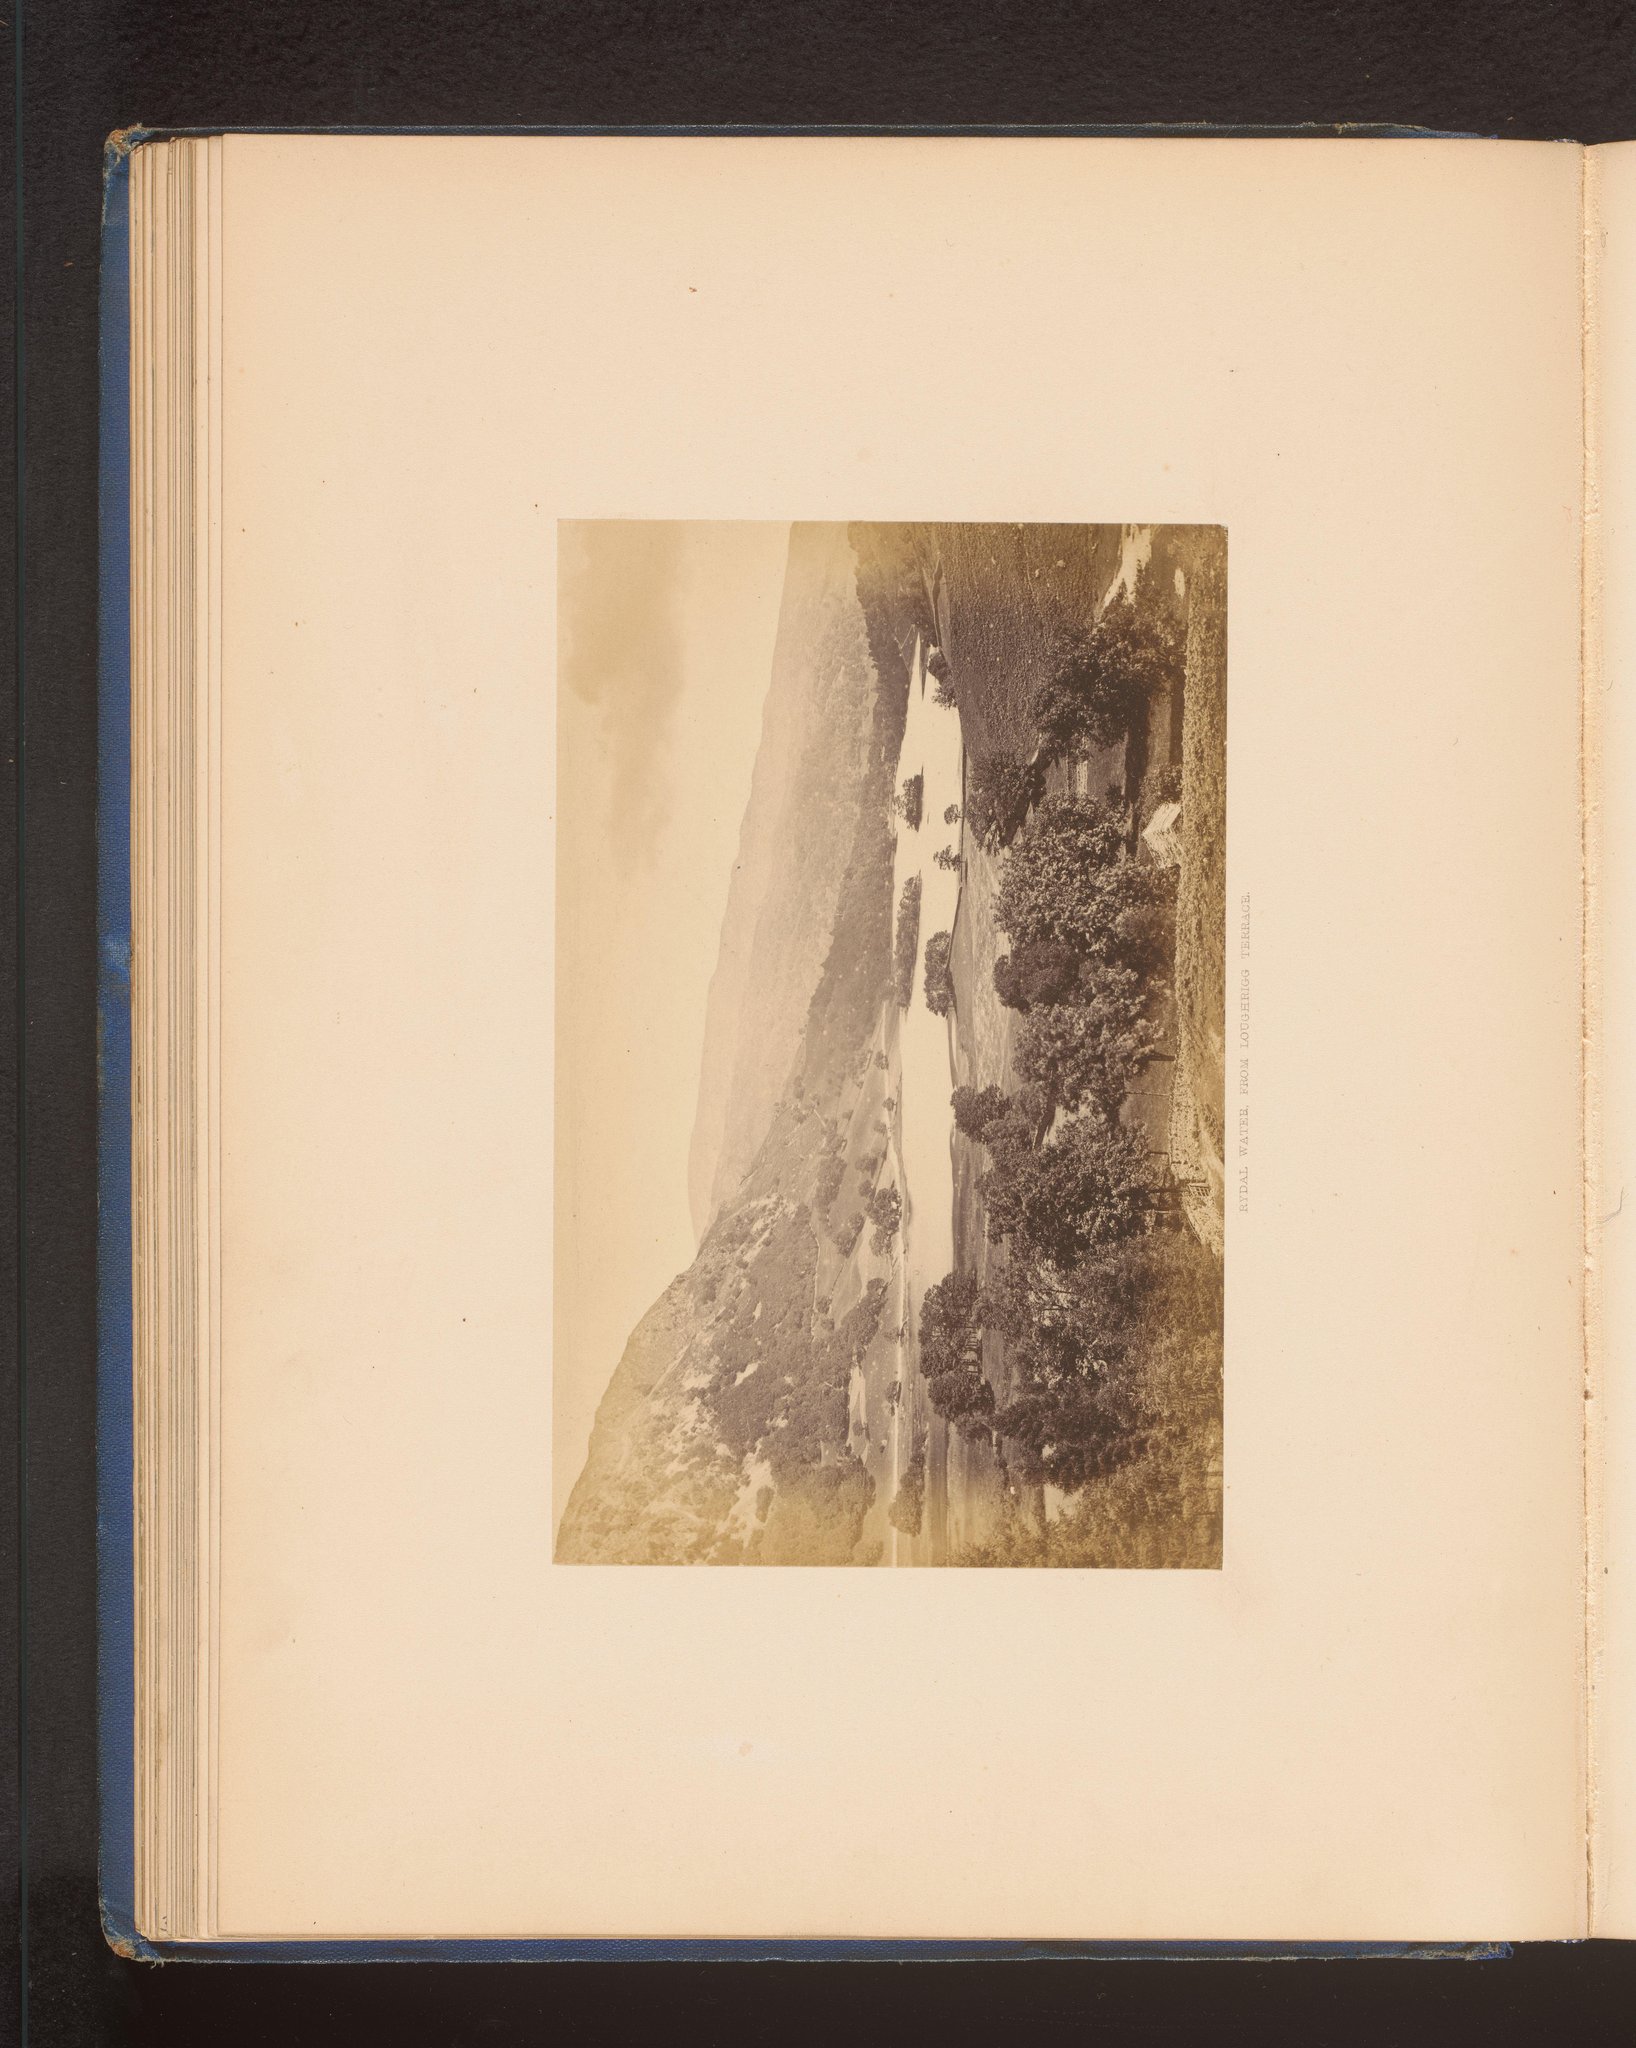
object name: photograph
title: Gezicht over Rydal Water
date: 1857-1867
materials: photographic support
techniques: albumen print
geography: lake district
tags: waterfall